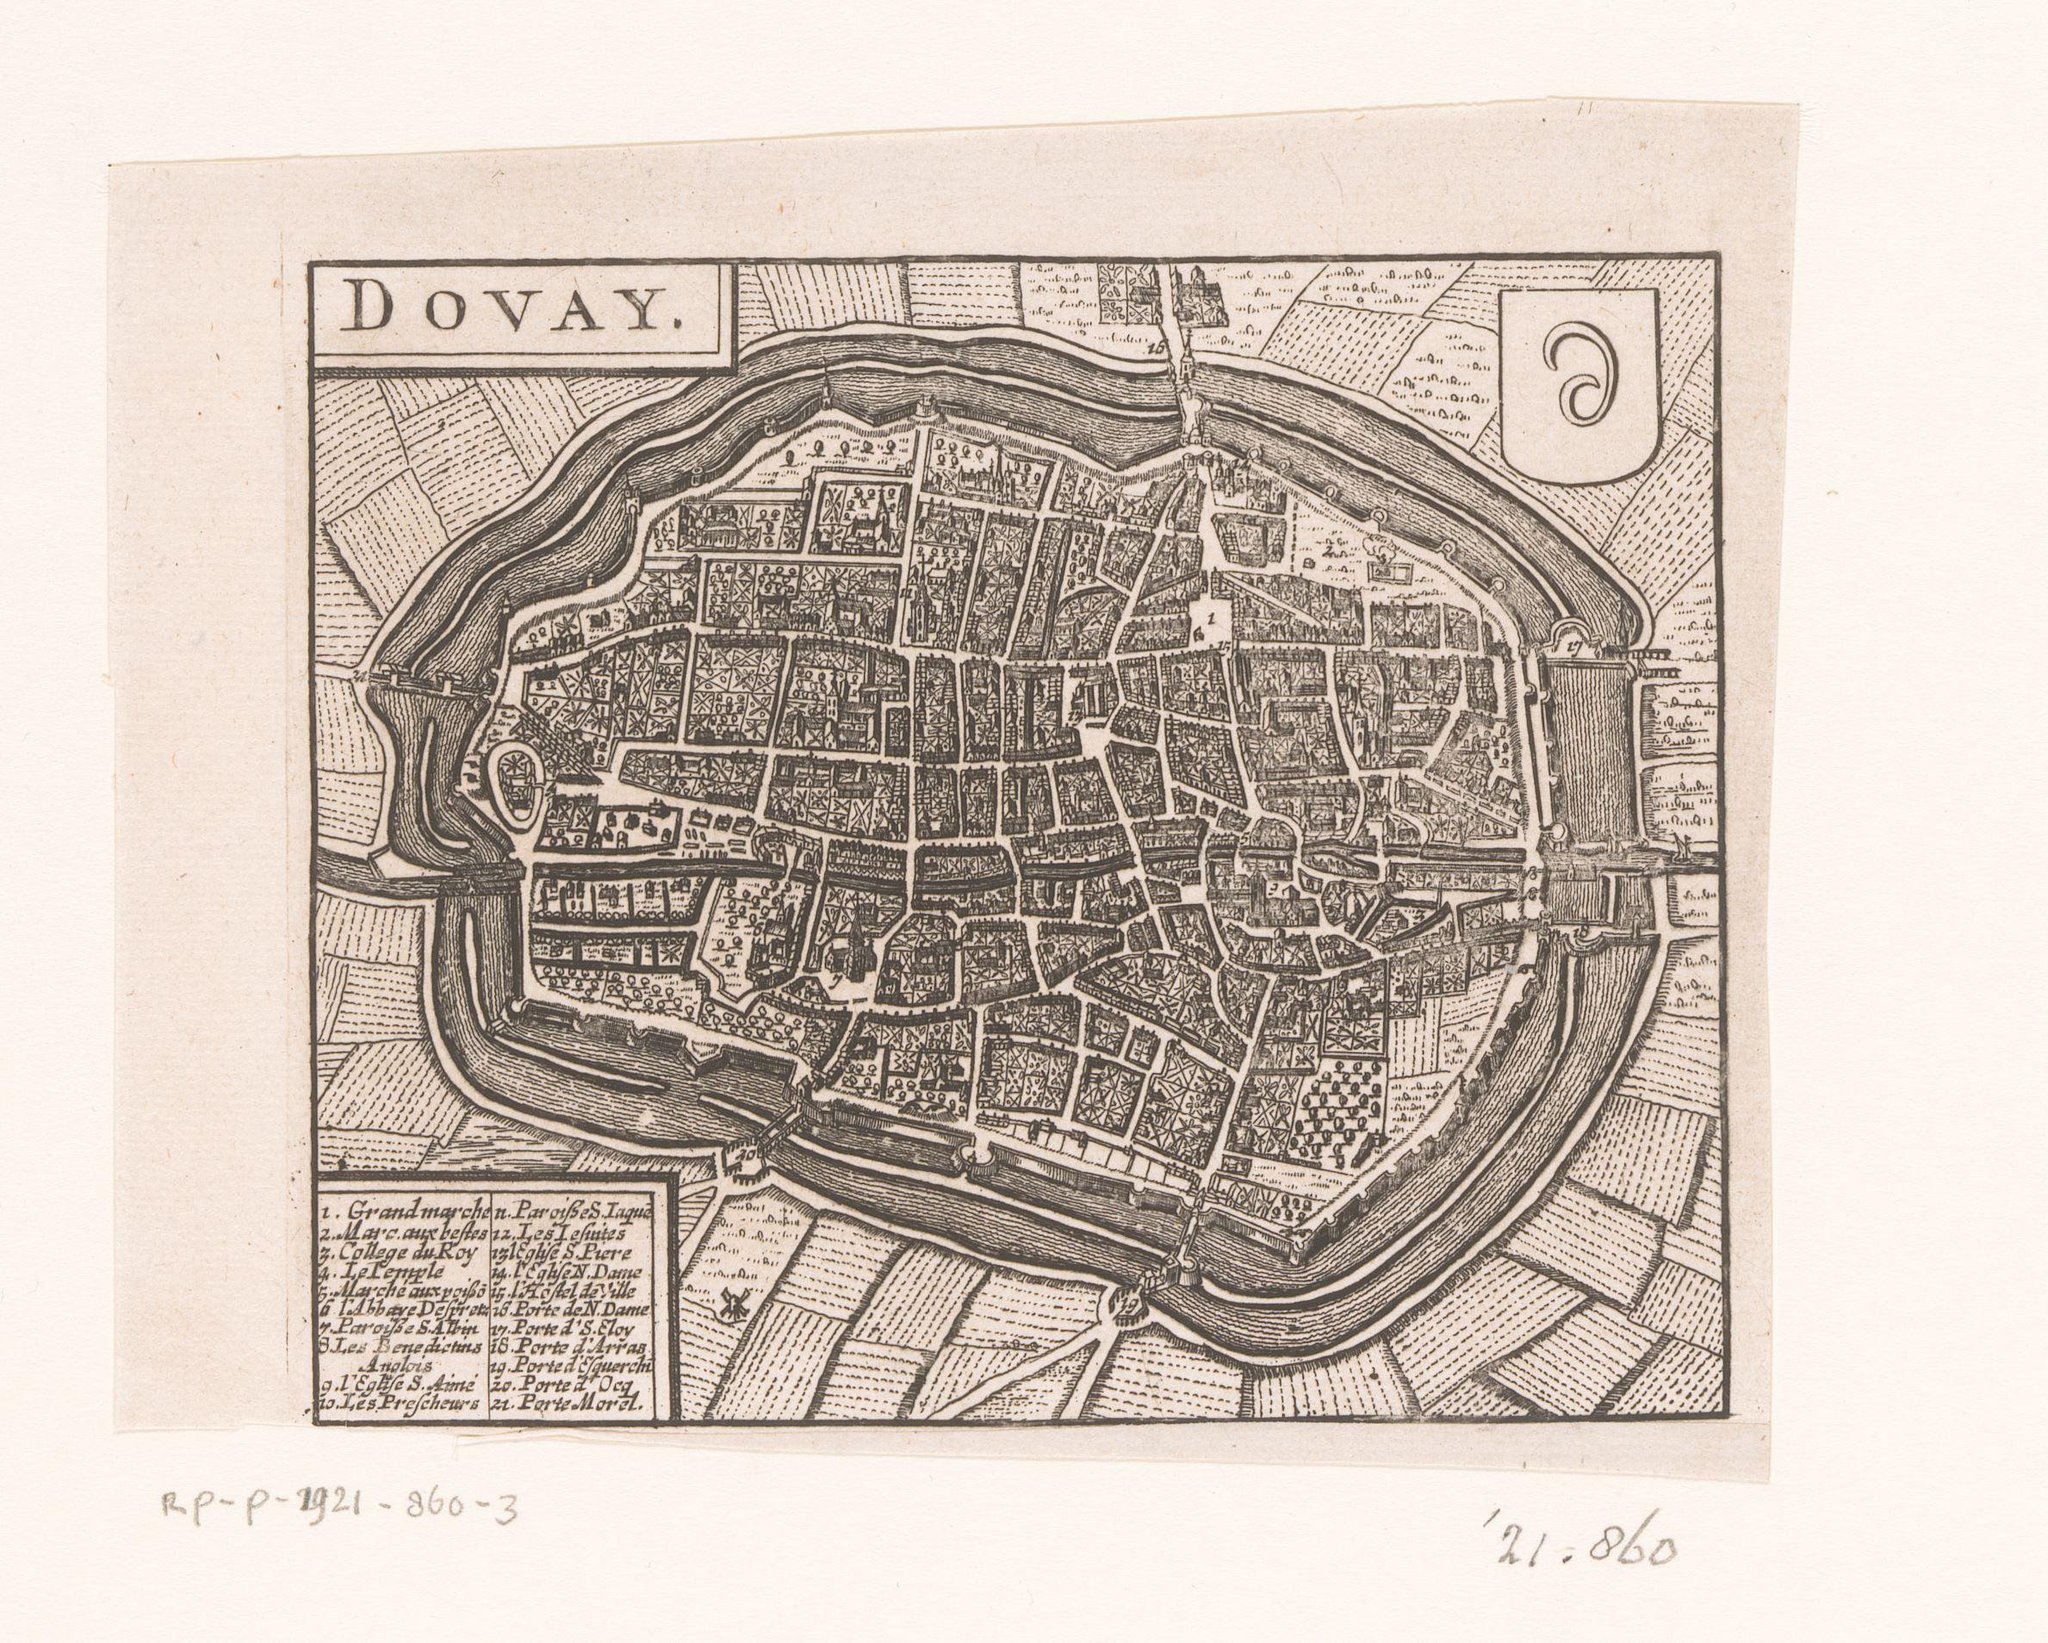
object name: print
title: Plattegrond van Douai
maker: Anonymous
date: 1652-1662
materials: paper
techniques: etching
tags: maps of cities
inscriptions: collector's mark: Lugt 2228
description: Plattegrond van de stad Douai met wapenschild en legenda.